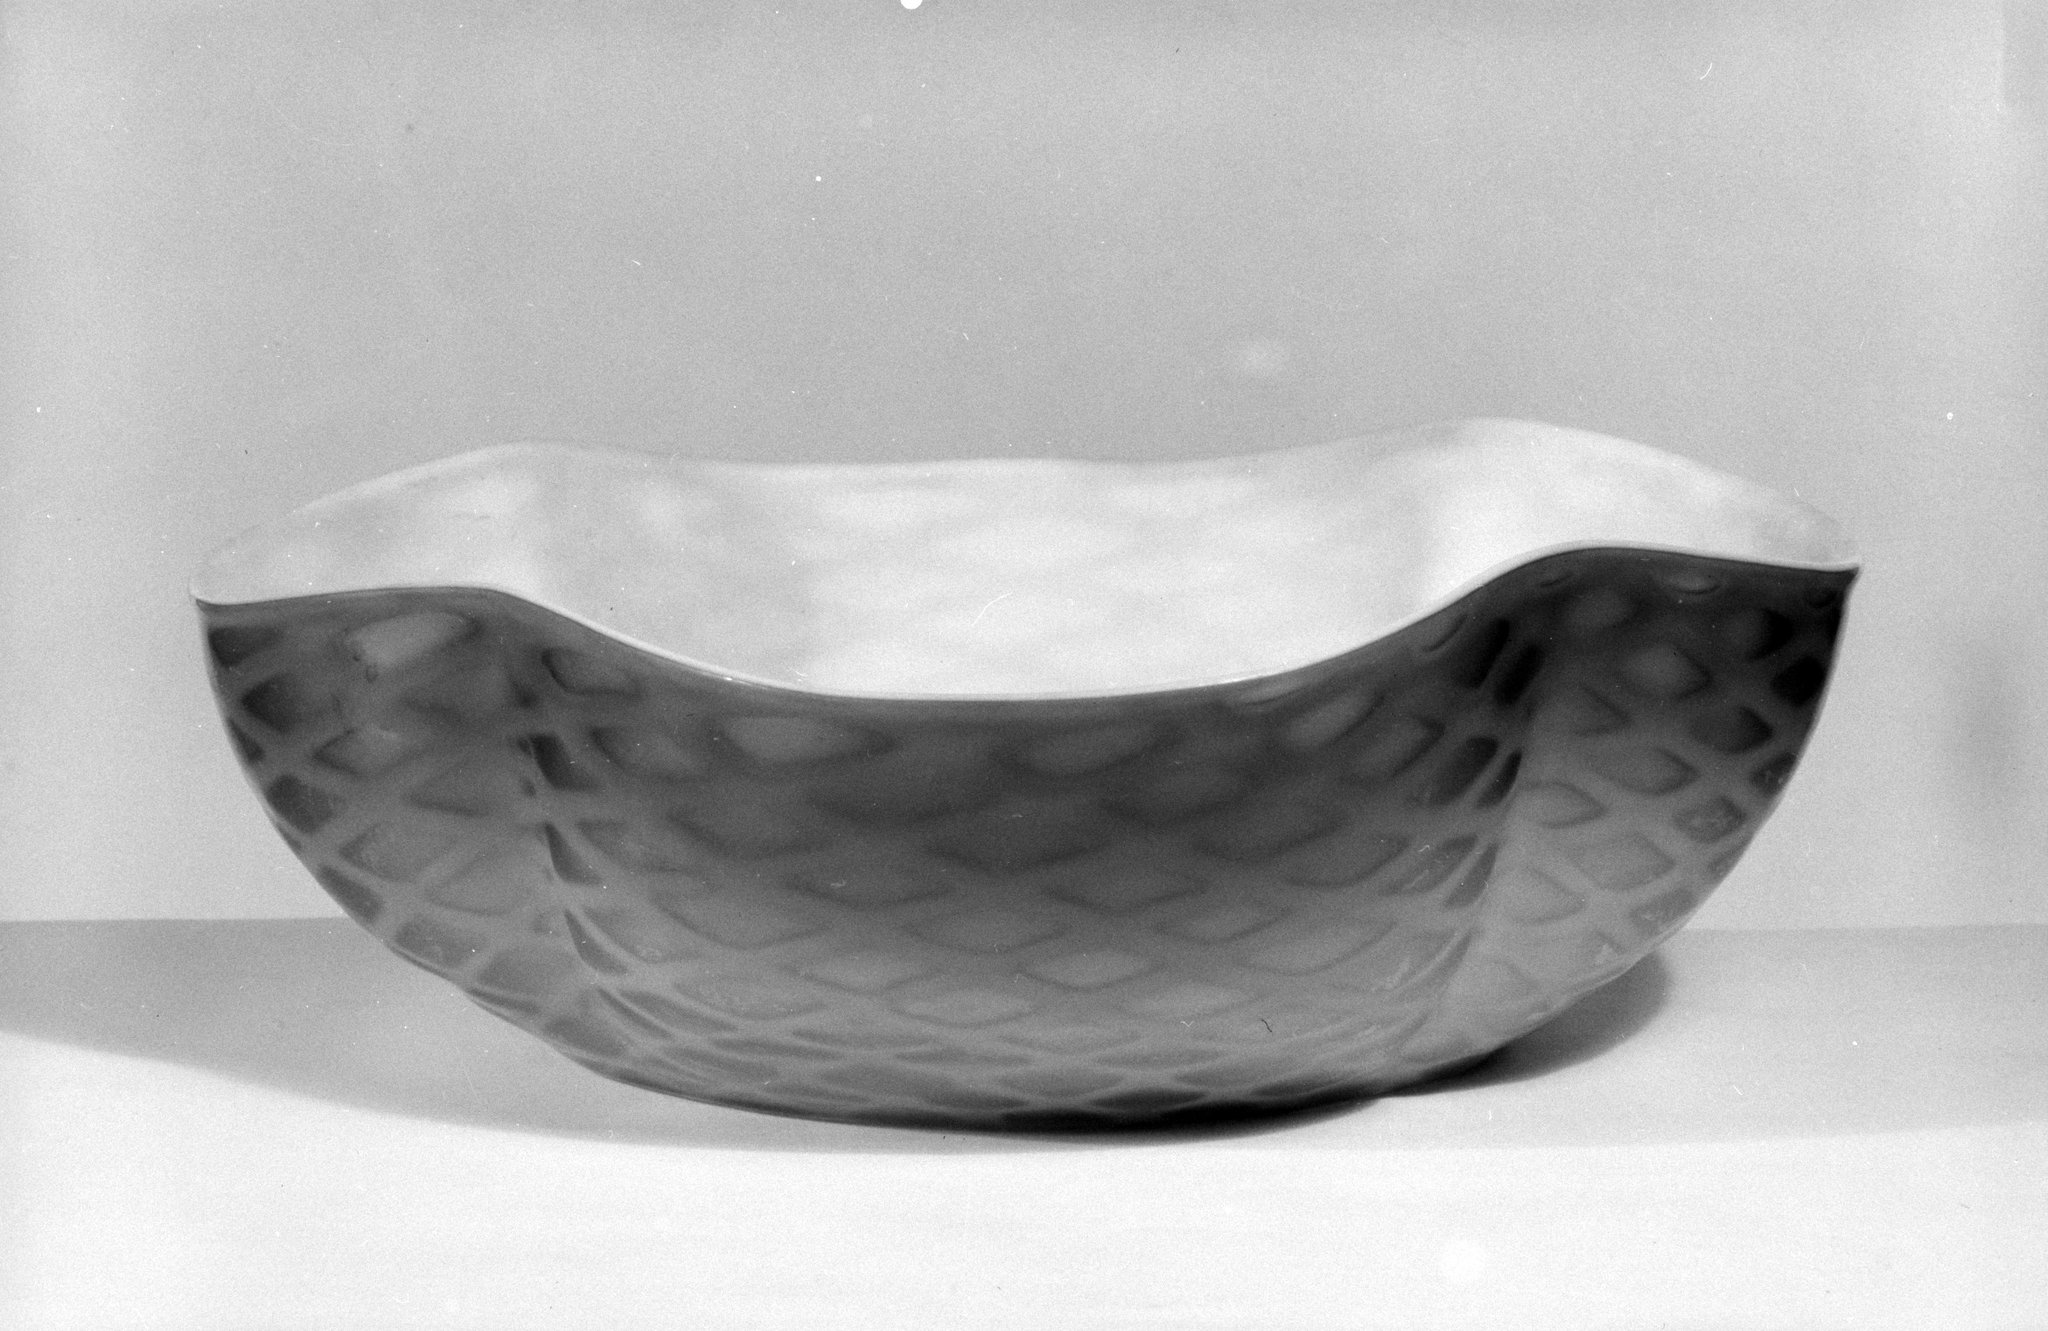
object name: bowl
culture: american or british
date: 1885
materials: glass, textile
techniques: glassblowing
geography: england